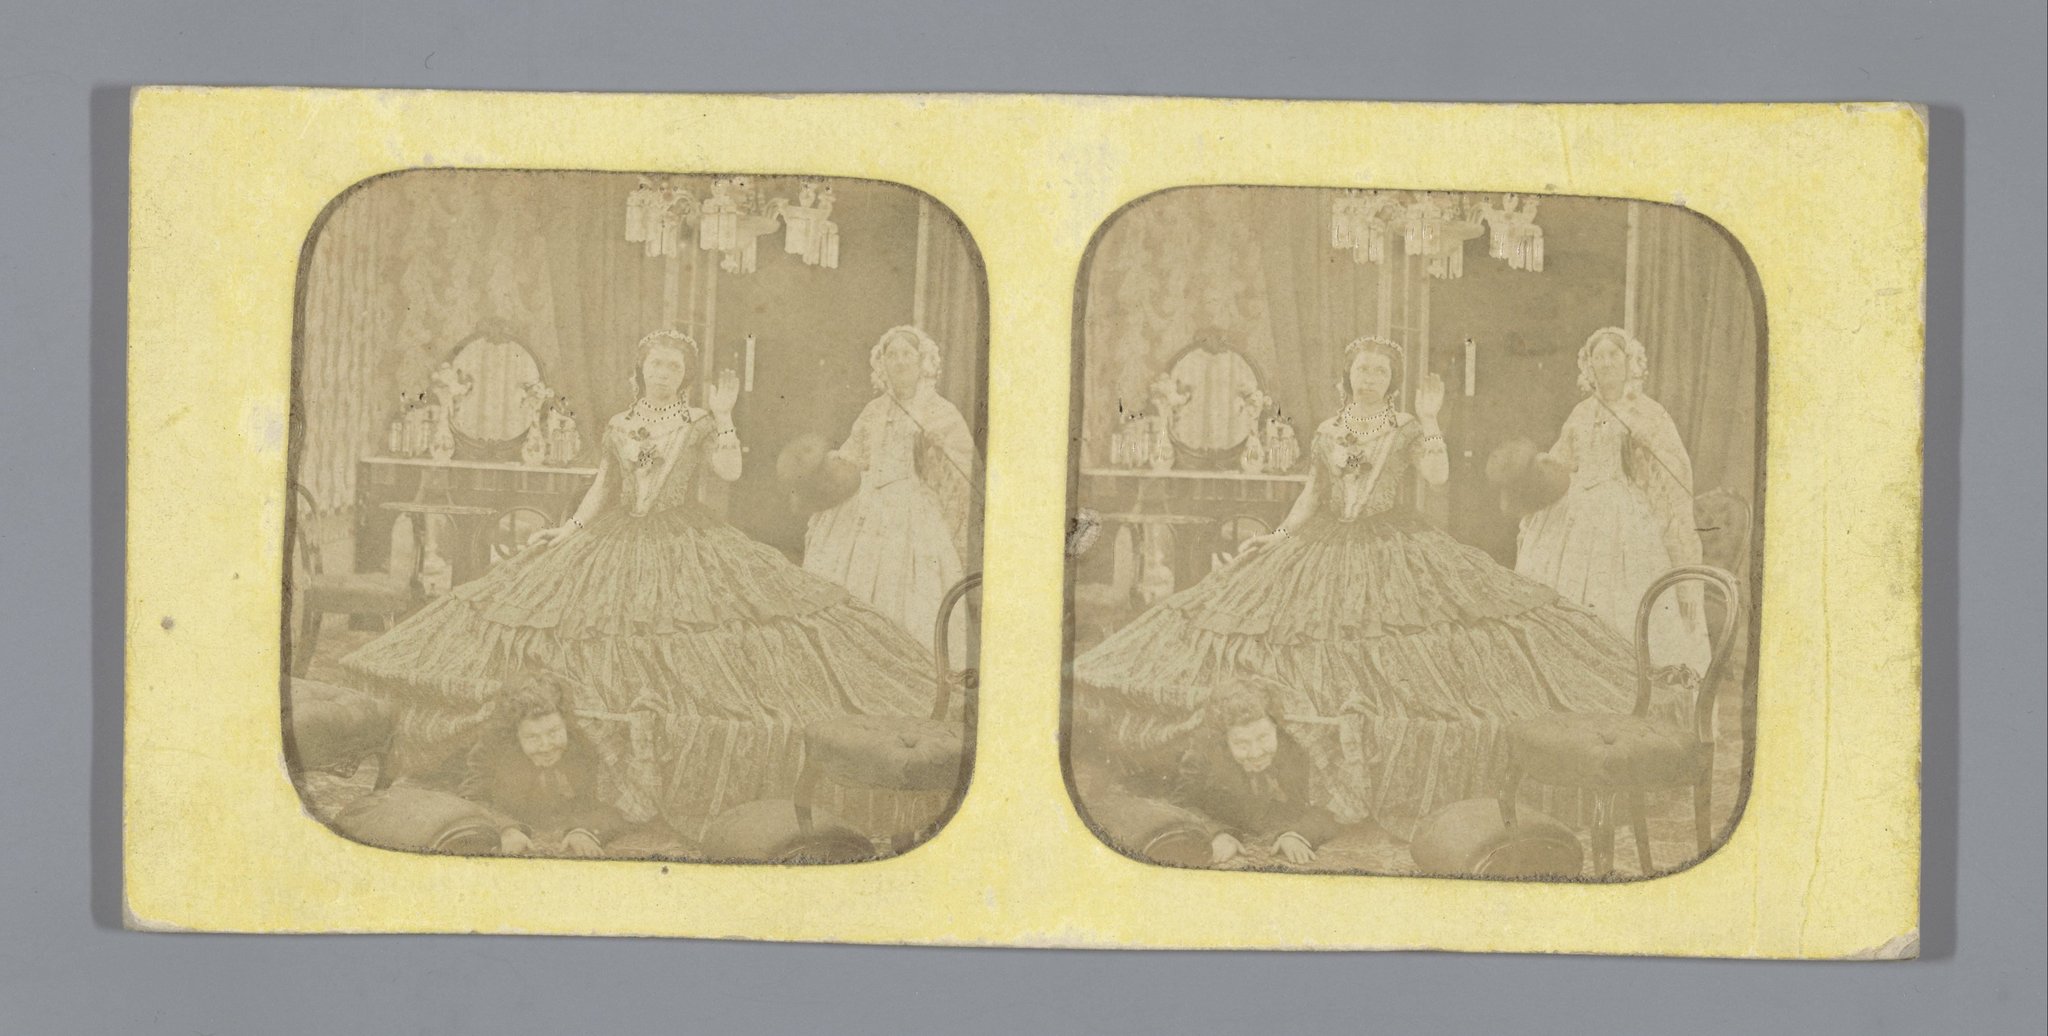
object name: tissue stereograph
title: Man verstopt zich onder crinolinerok van vrouw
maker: Anonymous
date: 1855-1875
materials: cardboard, paper, photographic support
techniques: albumen print, cutting, hand coloring, perforating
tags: hiding, hiding oneself